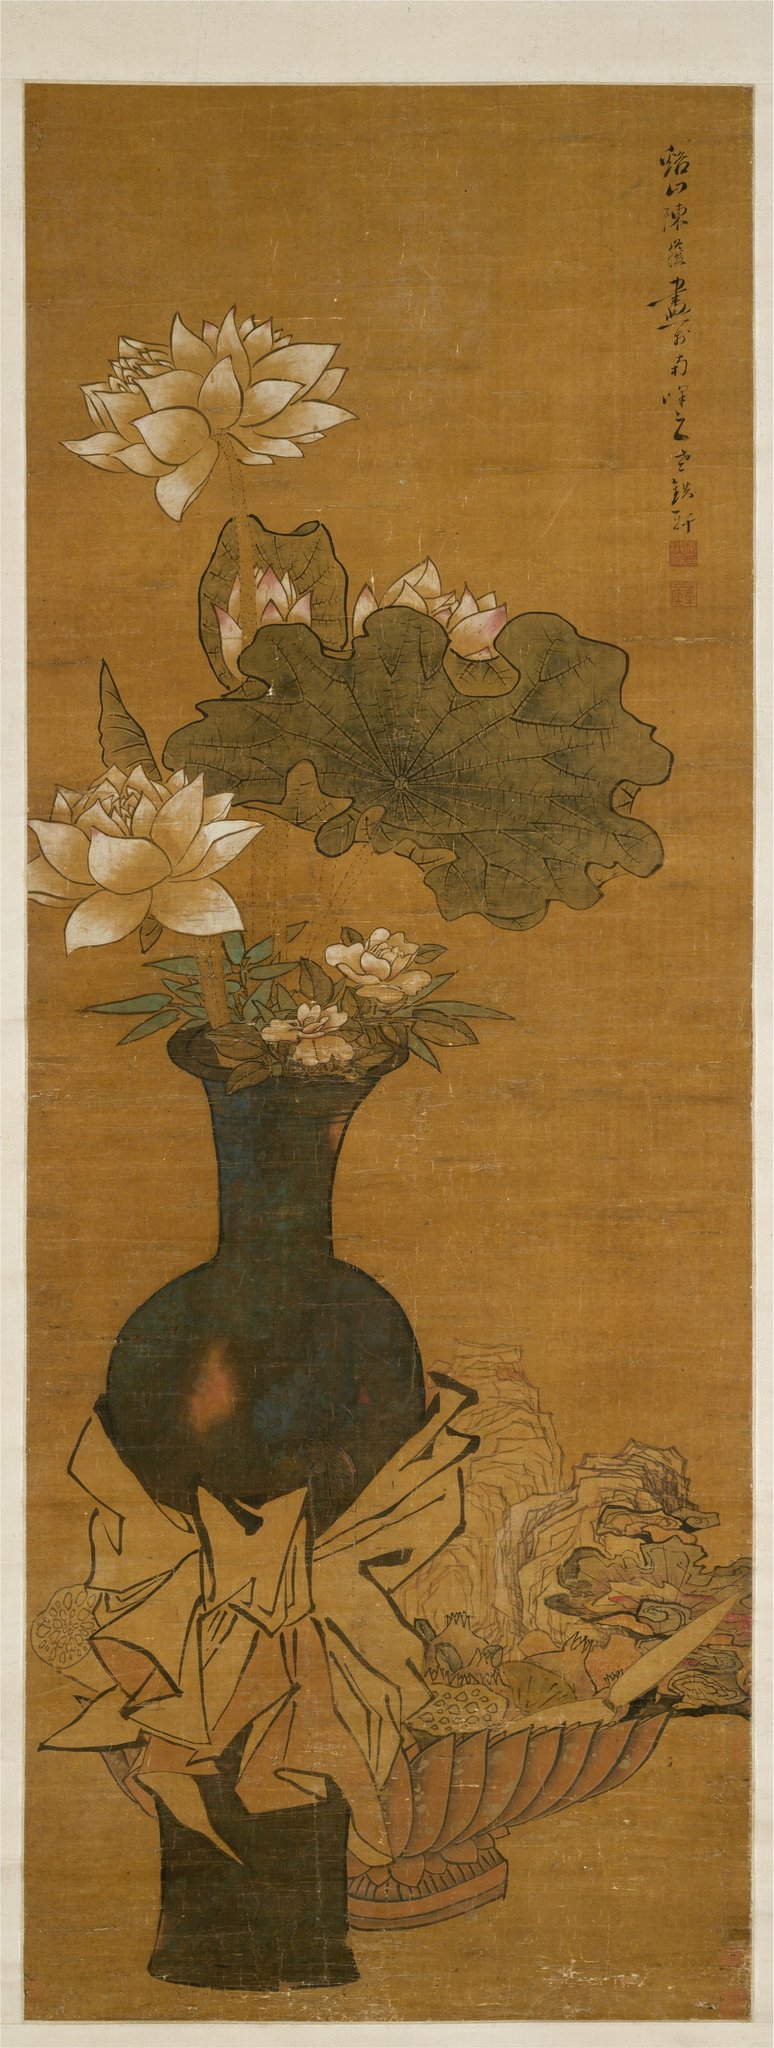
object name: hanging scroll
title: Vase of Flowers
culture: chinese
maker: chen hongshou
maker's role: artist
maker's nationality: chinese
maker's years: 1598-1652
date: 1350-1750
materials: ink, silk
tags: flowers